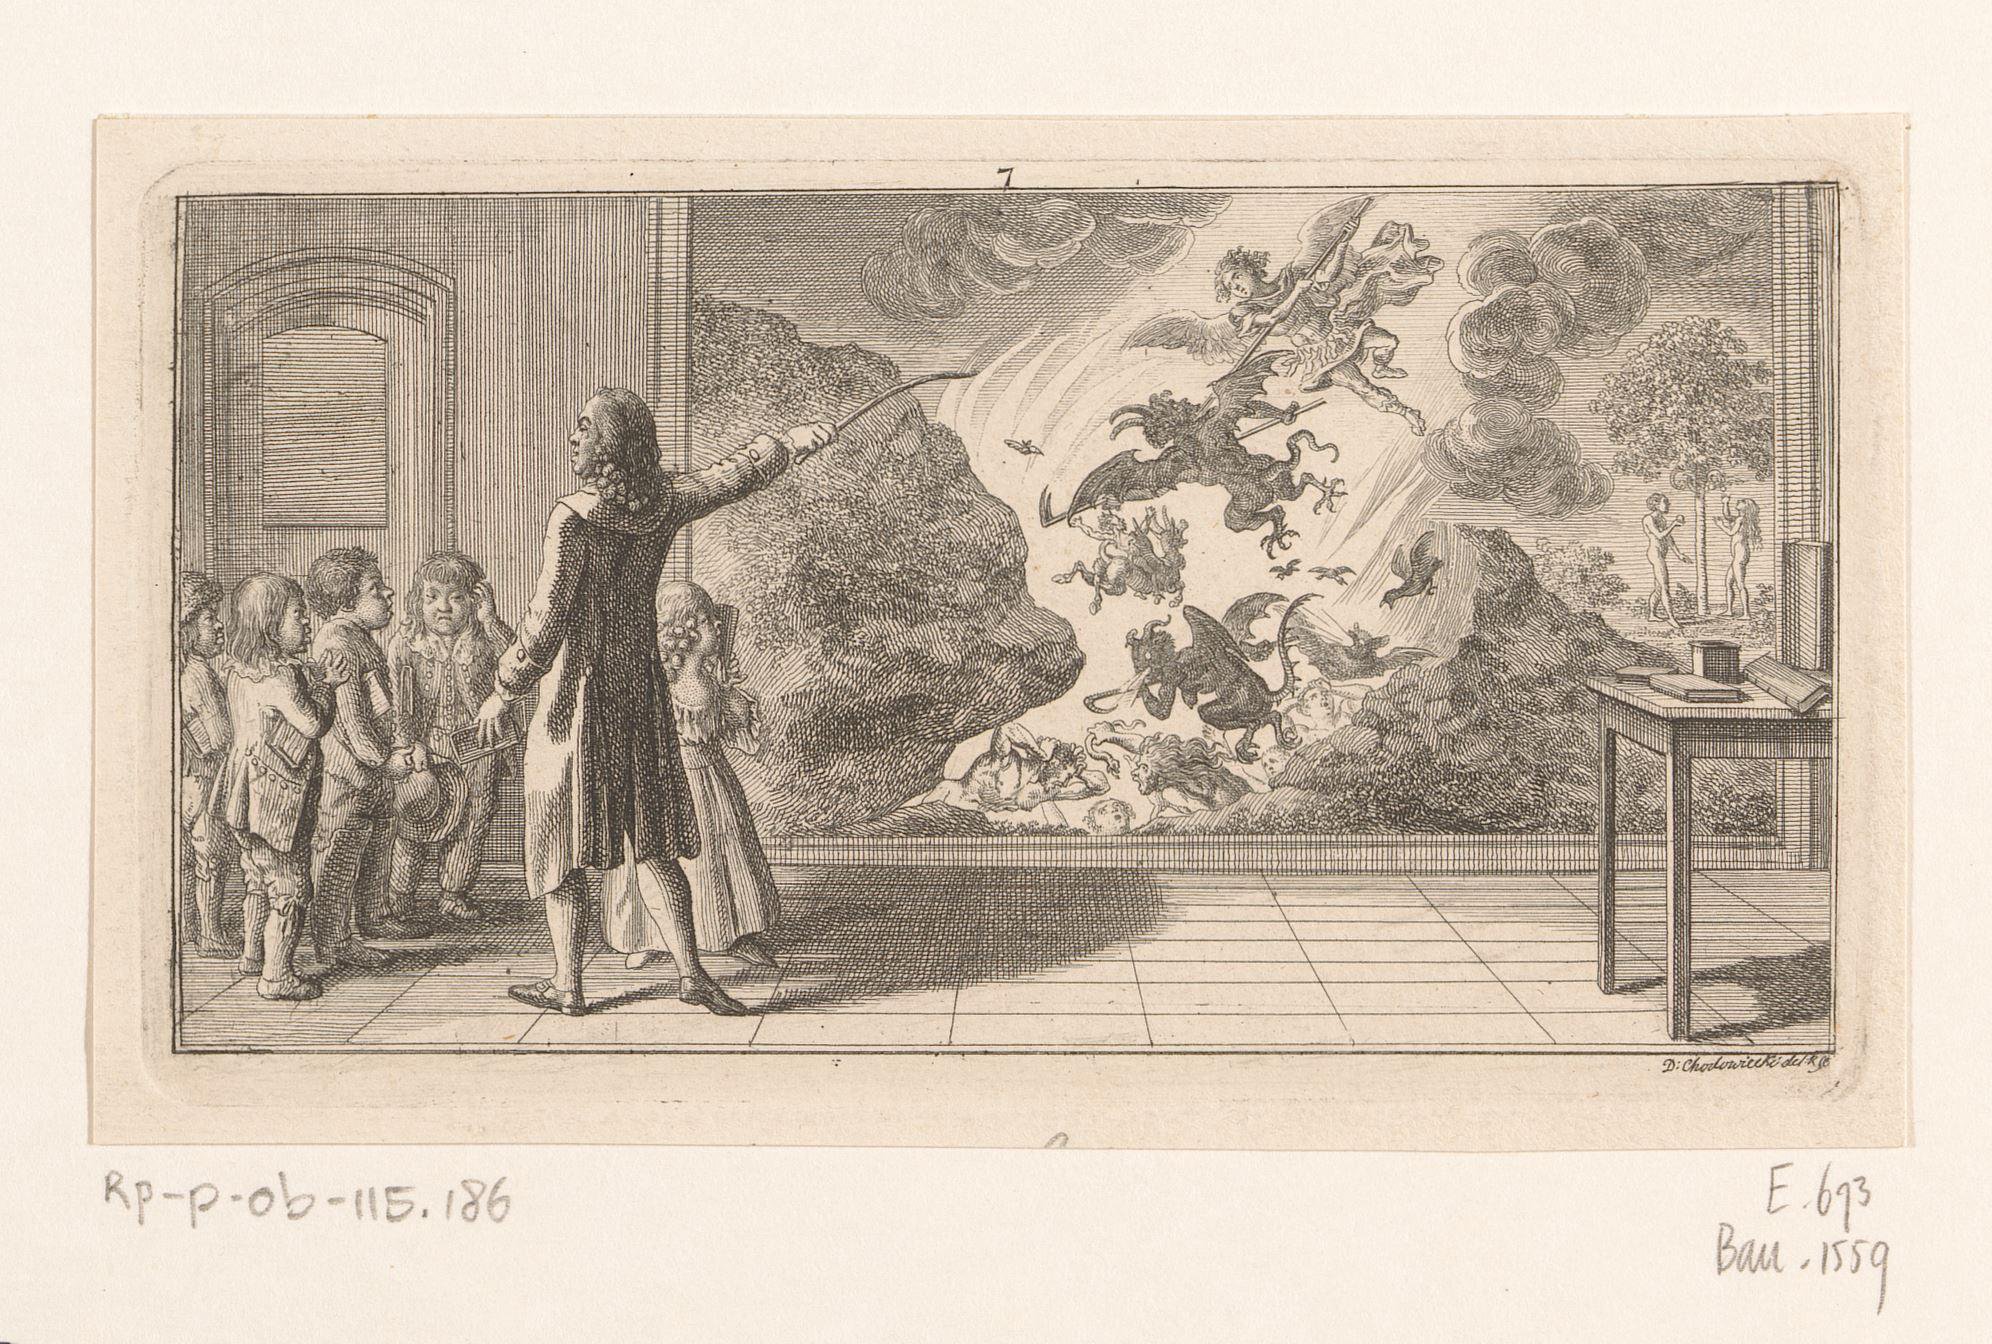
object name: print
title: Les van de schoolmeester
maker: daniel nikolaus chodowiecki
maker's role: draughtsman, print maker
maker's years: 1726-1801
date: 1791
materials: paper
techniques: etching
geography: berlin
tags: adam and eve holding (and possibly eating) the fruit, utopia, teacher and pupil, education, the archangel michael (and other angels) casting the rebel angels out of heaven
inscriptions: collector's mark: Lugt 2228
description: Prent gebruikt voor: Ziegenhagen, Franz Heirnich. Lehre von dem richtigen Verhältnis zu den Schöpfungswerken, und durch öffentliche Einfürung derselben allein bewürkende algemeine Menschbeglükkung (...). Hamburg: s.n., 1792.